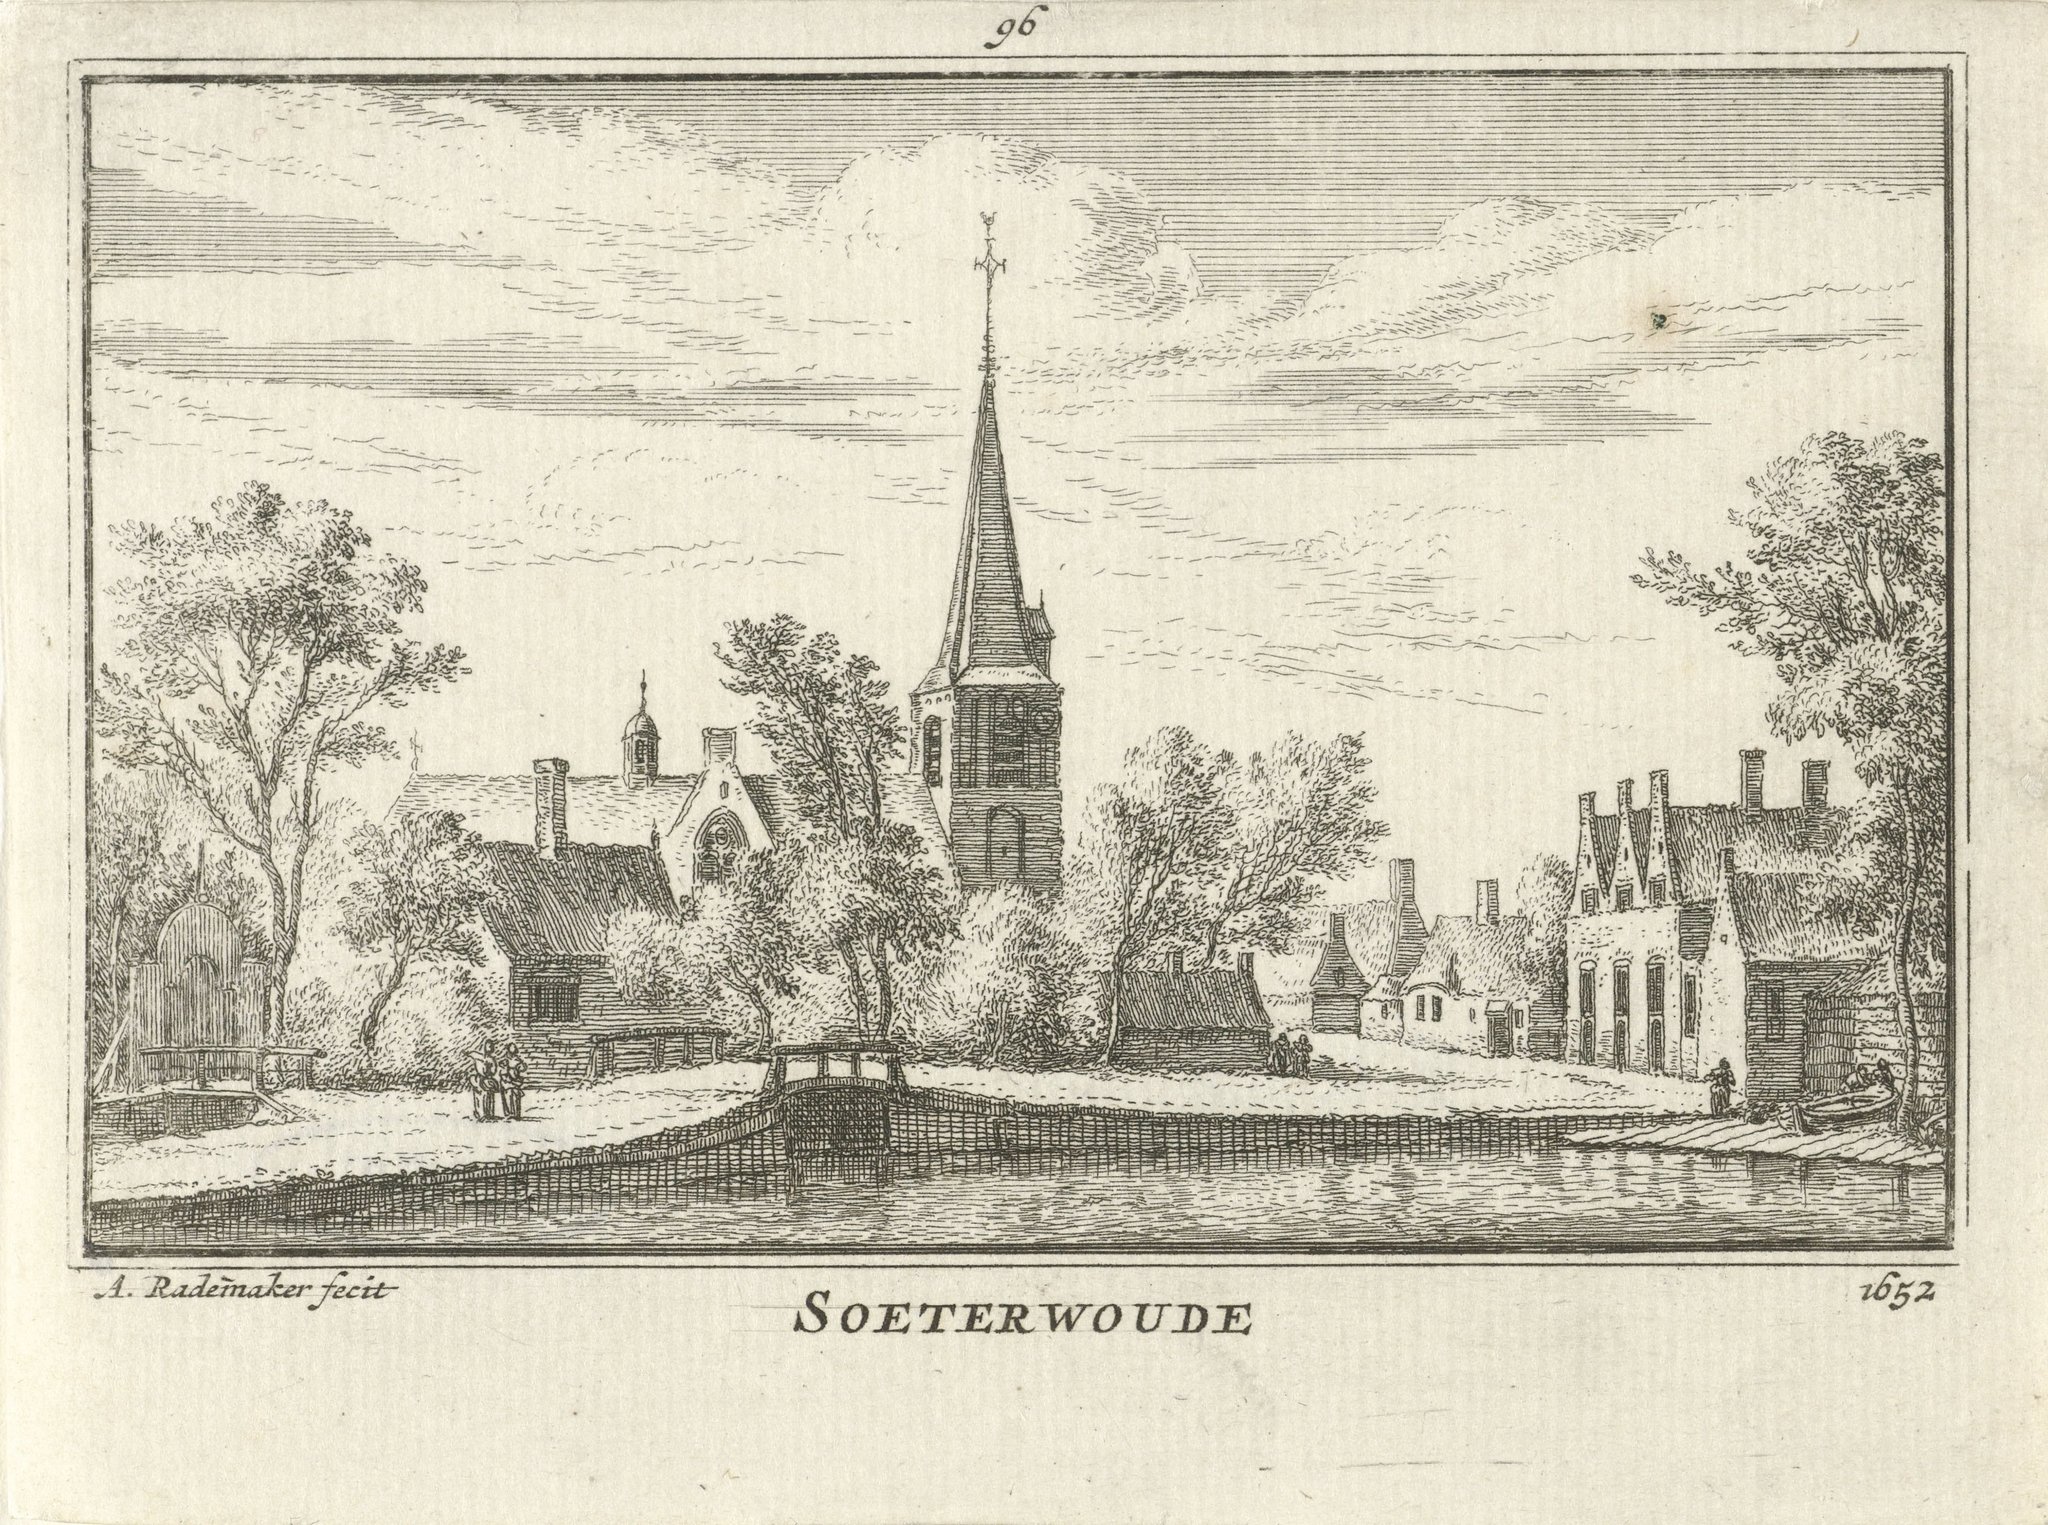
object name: print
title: Gezicht op Zoeterwoude, 1652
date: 1727-1733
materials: paper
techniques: etching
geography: amsterdam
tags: prospect of village, silhouette of village, village street, church (exterior)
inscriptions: collector's mark: Lugt 2228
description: Illustratie uit: Abraham Rademaker, Matthaeus Brouërius van Niedek, Isaac Le Long, Kabinet van Nederlandsche en Kleefsche outheden en (...) voorname stads- en landgebouwen, Willem Barents en Antoni Schoonenburg: Amsterdam, 1727-1733, ill. nr. 96.